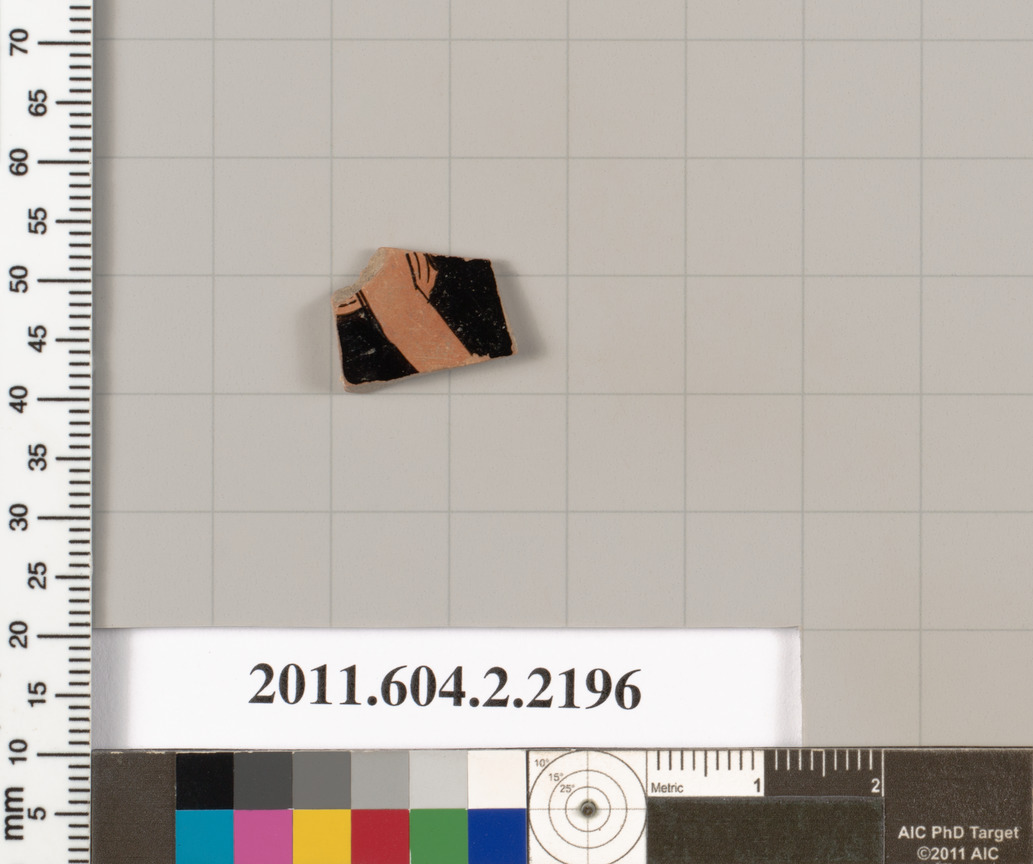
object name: pot fragment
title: Terracotta fragment of a pot; unglazed on the inside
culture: greek, attic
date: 490-470 BCE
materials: terracotta